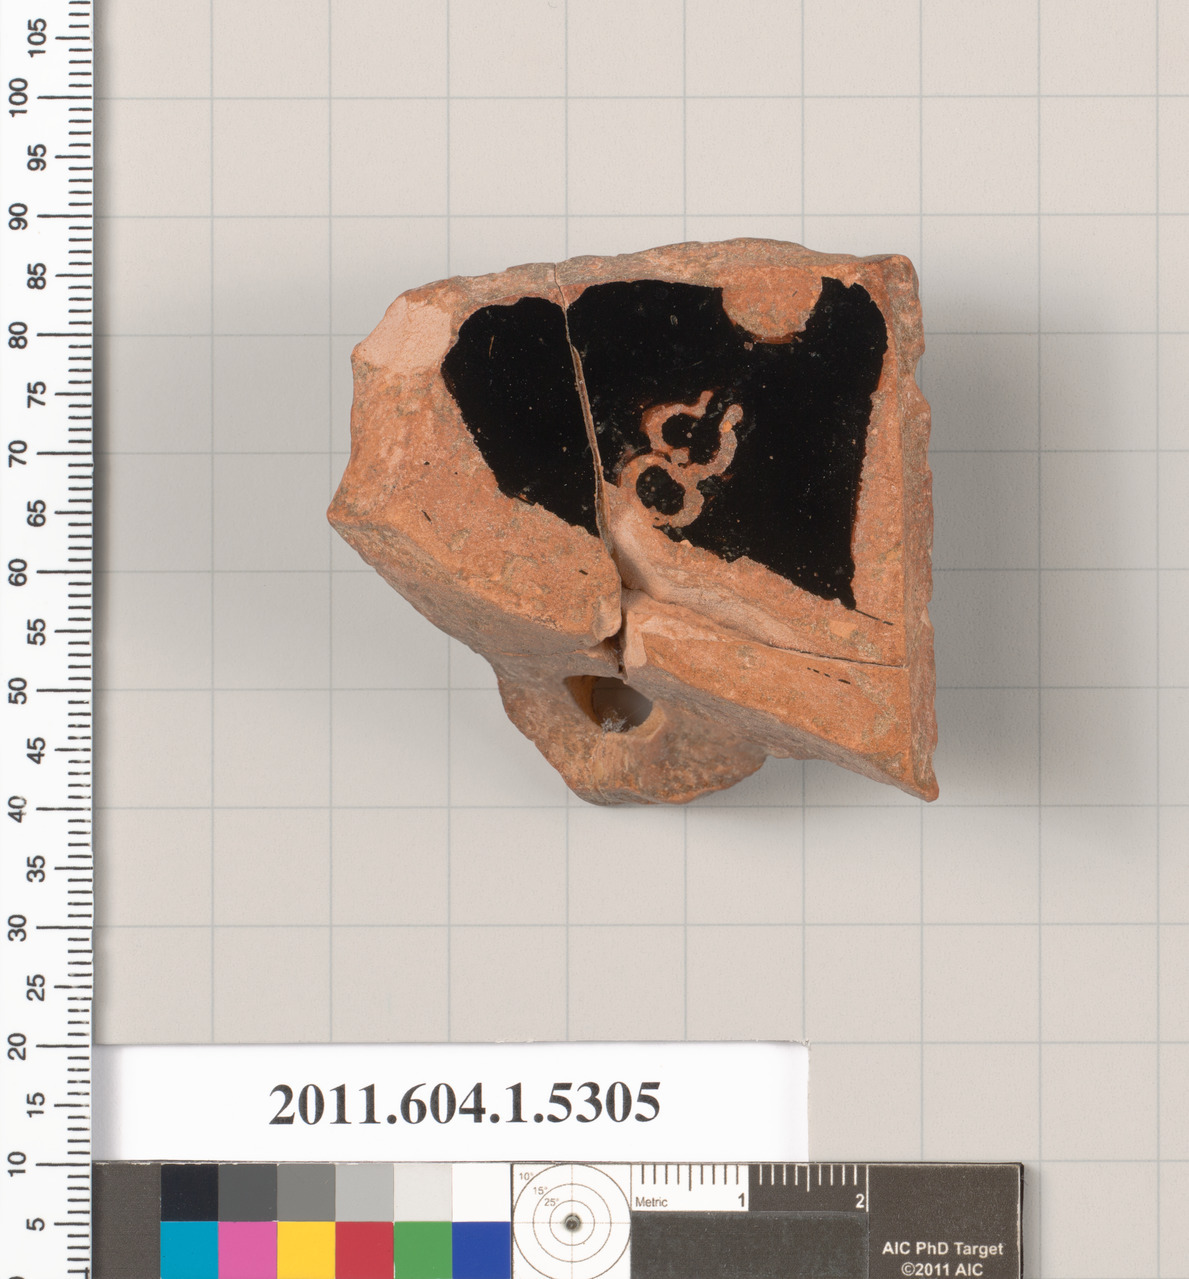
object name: kylix fragment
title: Terracotta fragment of a kylix (drinking cup)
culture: greek, attic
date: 475-451 BCE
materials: terracotta